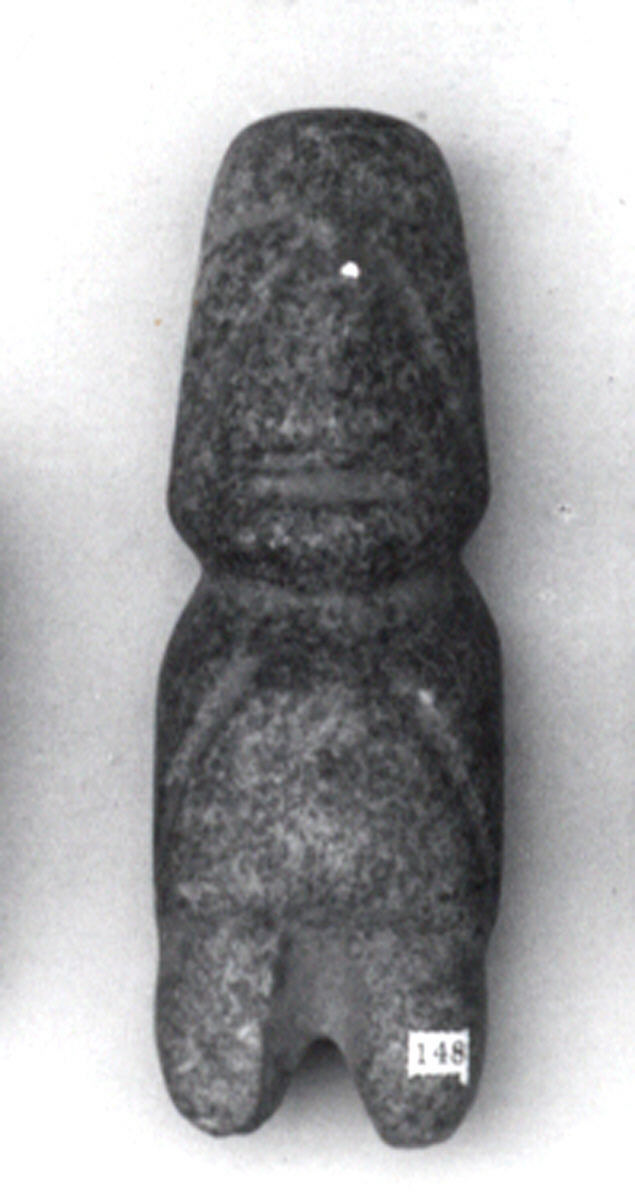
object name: figure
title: Standing Figure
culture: guerrero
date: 1-1500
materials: stone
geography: mexico